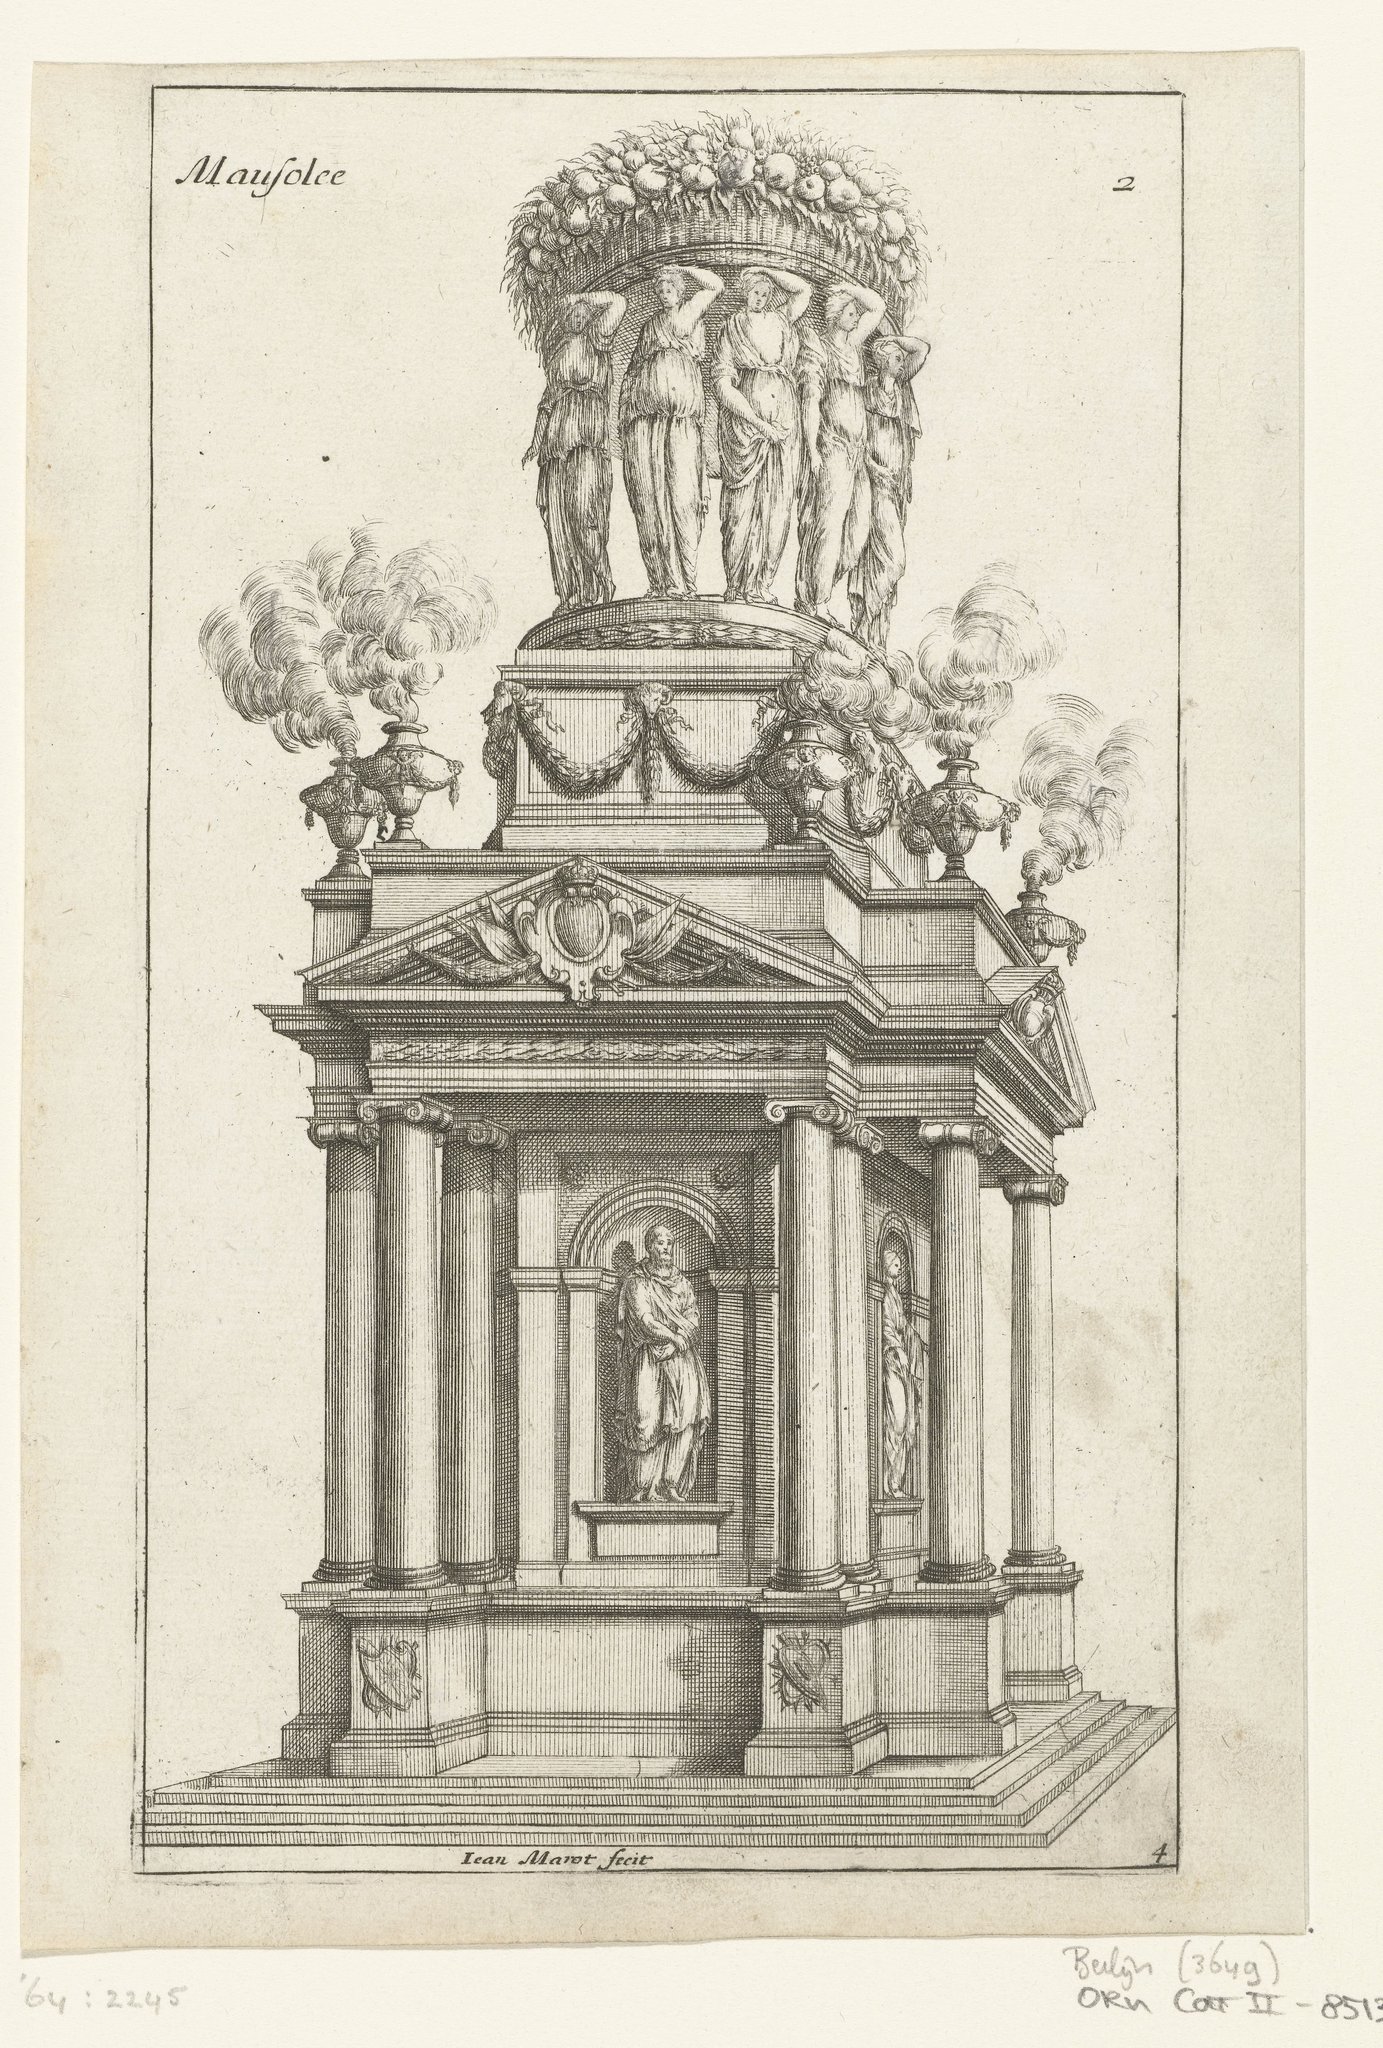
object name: ornament print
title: Mausolee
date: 1629-1716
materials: paper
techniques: engraving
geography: paris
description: Bovenop het monument staan kariatiden in een cirkel; rechtsboven staat het cijfer 2.